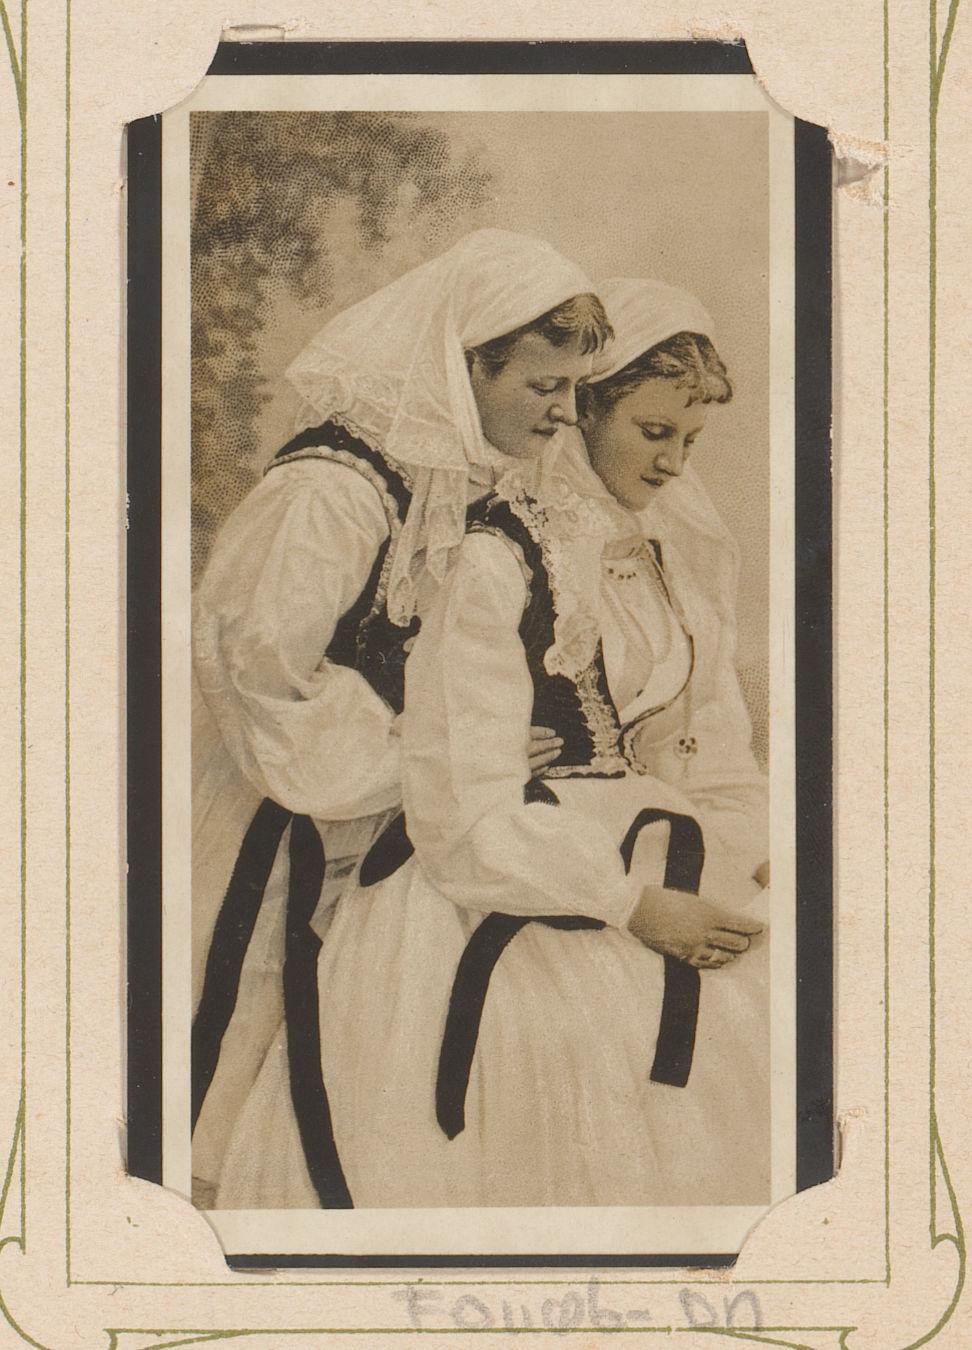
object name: photograph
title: Twee jonge Zweedse vrouwen in traditionele kleding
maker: Anonymous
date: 1904-1905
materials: photographic support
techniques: gelatin silver print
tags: adult woman, folk costume, regional costume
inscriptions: inscription: ‘No. 6./ Jonge Meisjes. Prov. Blekinge.’